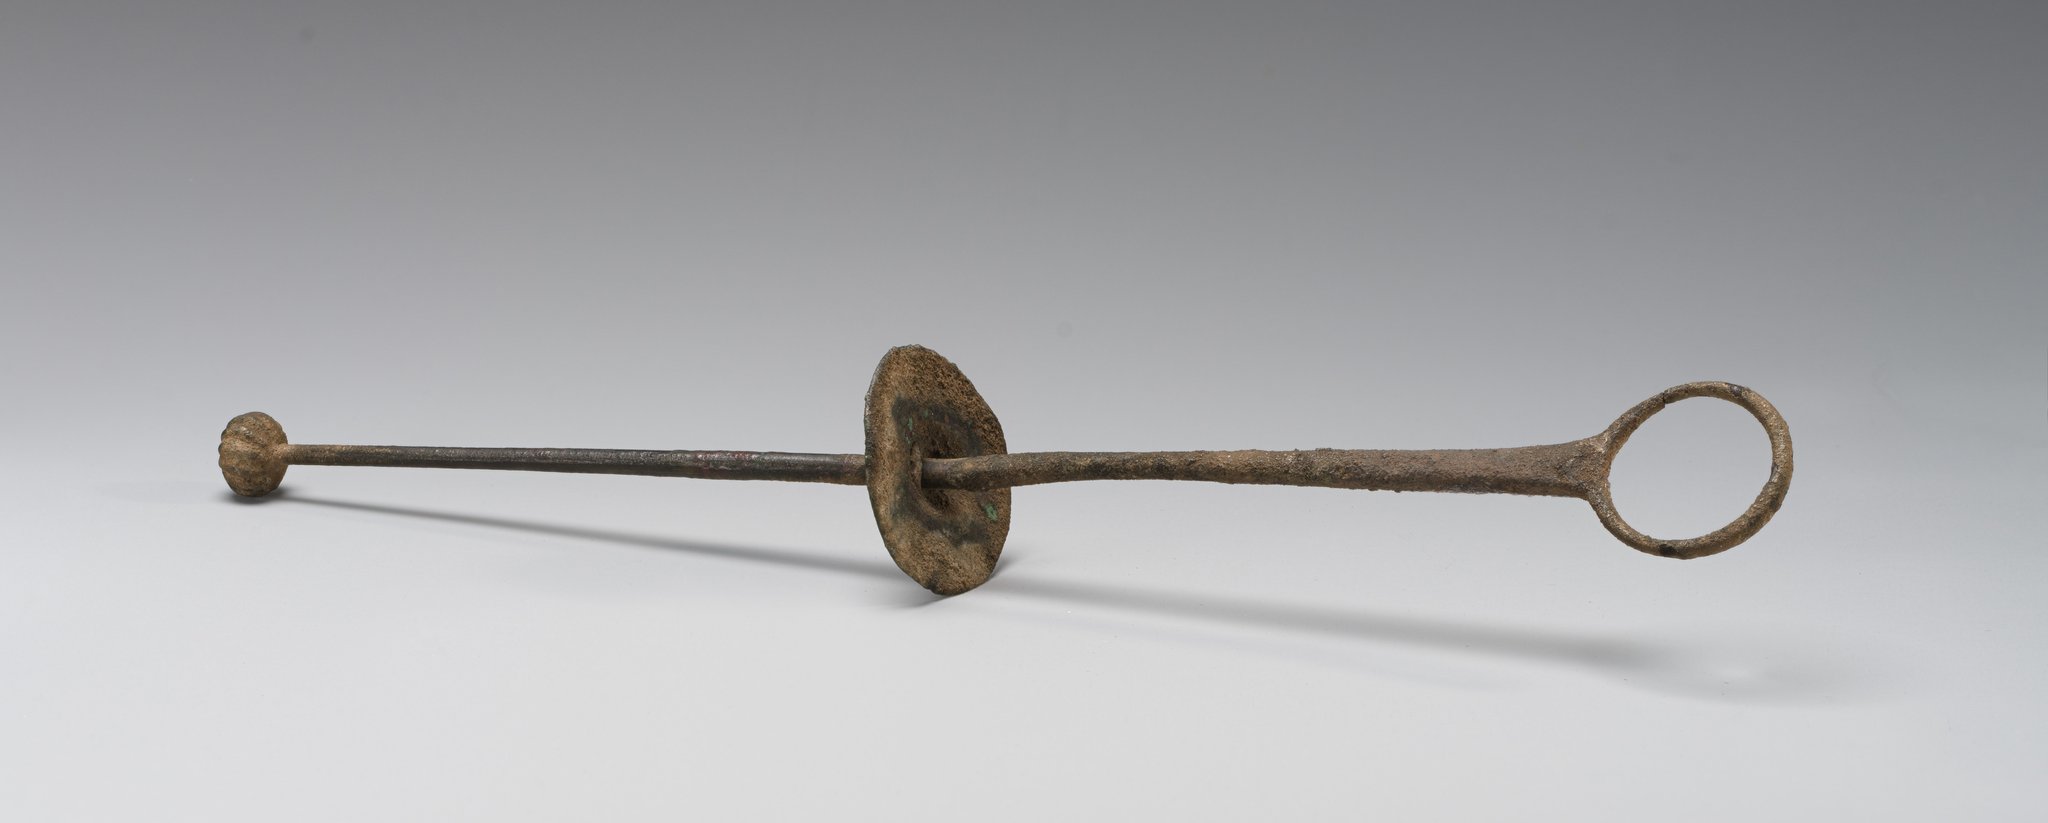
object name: rod, dipping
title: Bronze dipping or stirring rod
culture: roman, cypriot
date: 1-200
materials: bronze